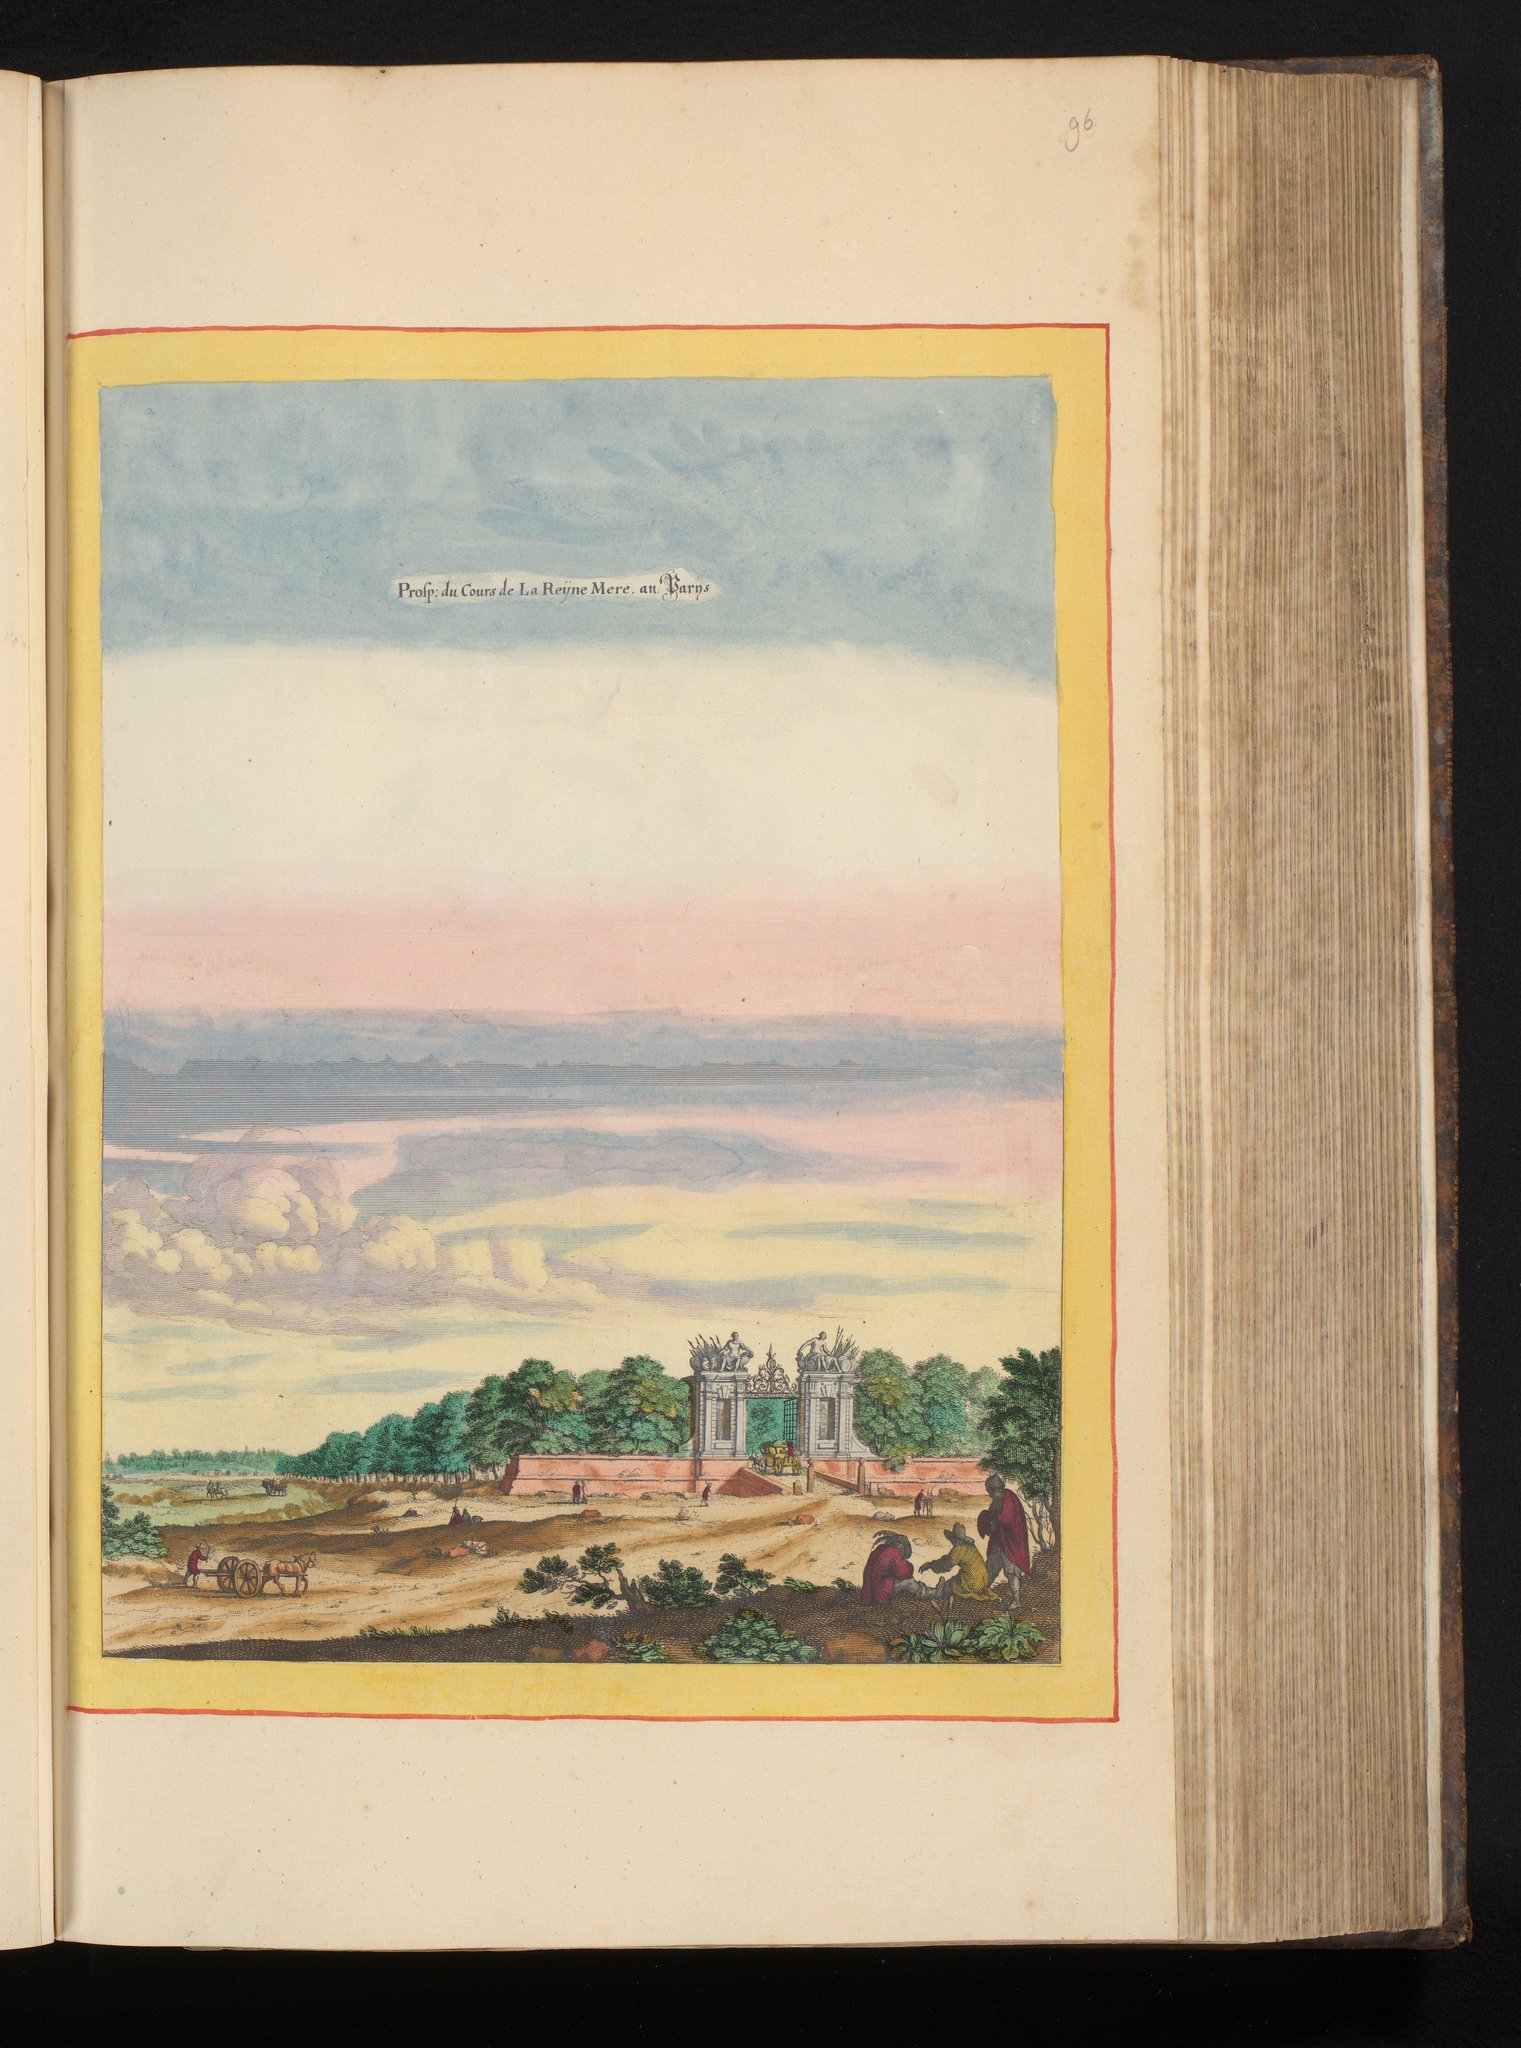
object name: print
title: Prosp. du Cours de La Reijne Mere au Parijs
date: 1655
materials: paper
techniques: engraving, etching, hand coloring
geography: the hague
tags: paris, anna van oostenrijk, palace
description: Prent origineel vervaardigd als boekillustratie voor: Zeiller, Martin. Topographia Galliae, oder Beschreibung und Contrafaitung der vornehmbsten und bekantisten Oerter in dem mächtigen und grossen Königreich Frankreich, 13 delen. Frankfurt am Main: Caspar Merian, 1655-1661. De prent werd voor het eerst gepubliceerd in deel 1: Topographia Galliae, 1655. De prent is langs de bovenrand van de voorstelling afgescheurd. Het bovenste gedeelte is hoger opgeplakt, zodat de lucht hoger is geworden en het formaat van de voorstelling past bij de andere groot formaatvoorstellingen in het album. De voorstelling is aan de bovenzijde aangevuld met een geschilderde lucht.